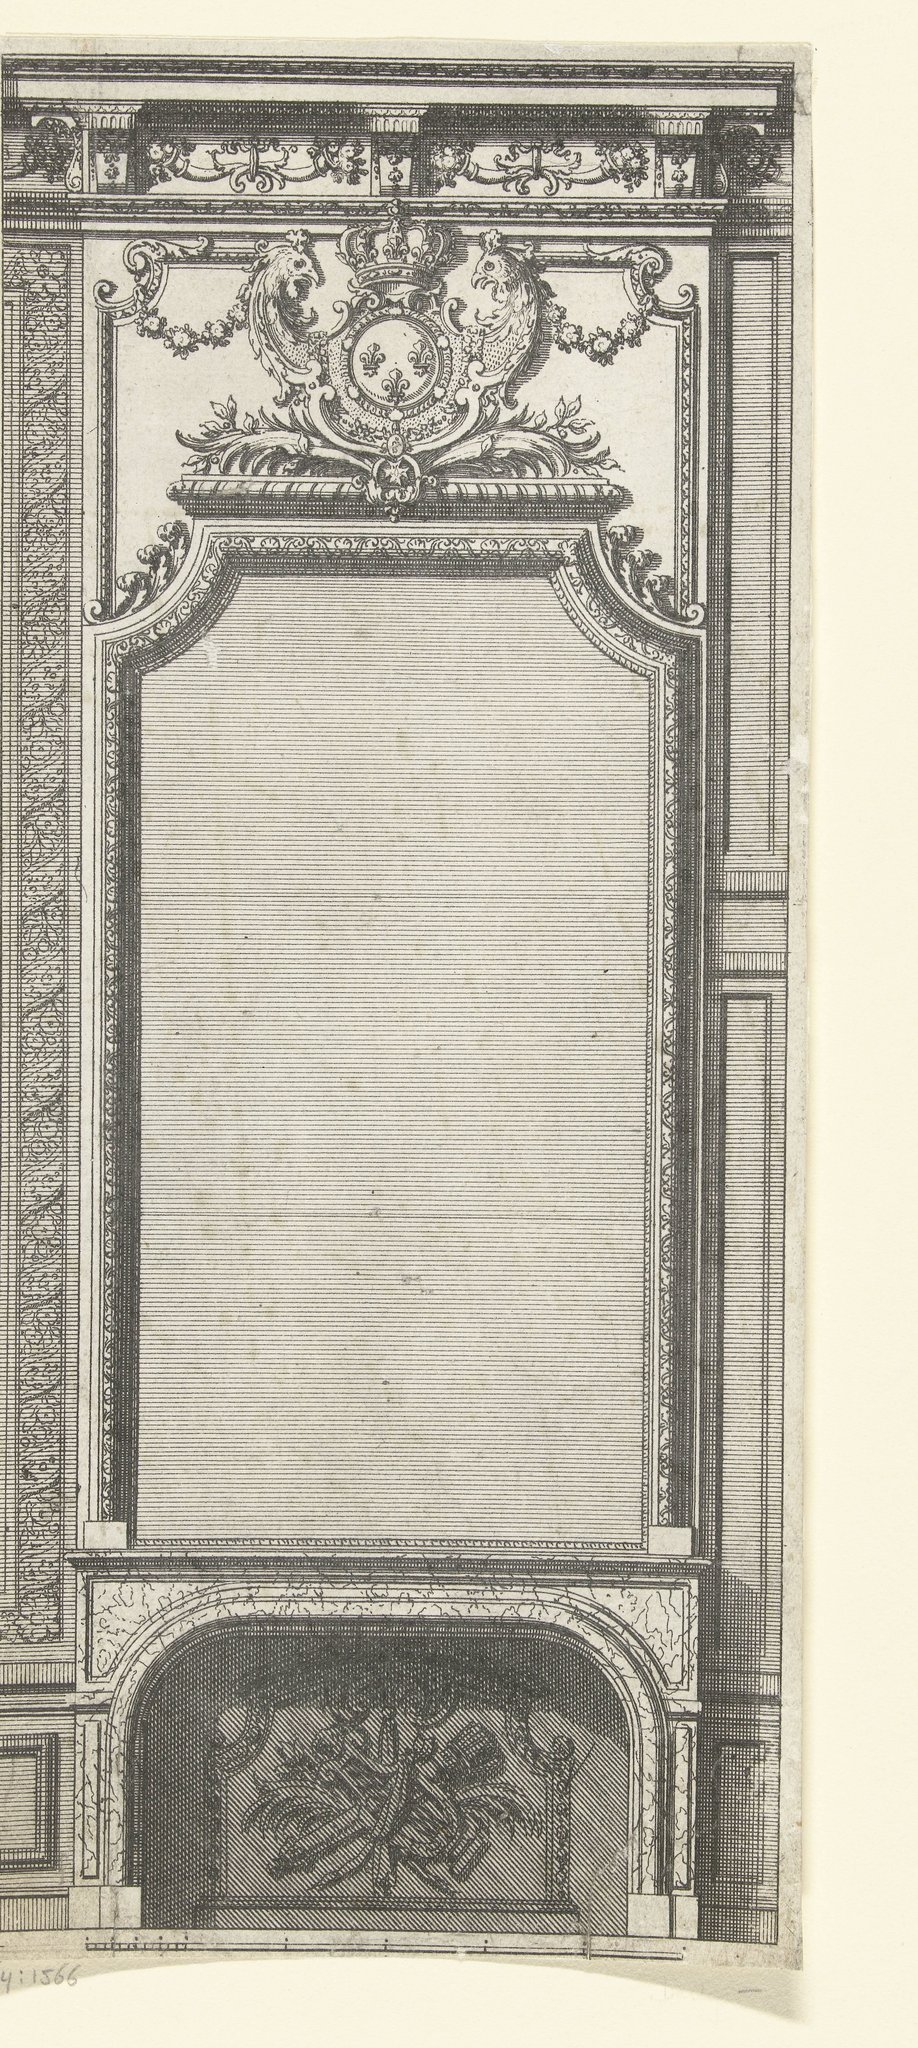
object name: ornament print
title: Schoorsteen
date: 1670-1699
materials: paper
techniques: etching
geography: paris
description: Niet in Berlin. Guilmard. Zie Fishe Kimball, The Creation of the Rococo, p.68 (vermeld reeks in Met.Mus.N.Y. als uniek). Zie ook: Metrop.Mus. Studies, Vol. V, p.274 e.v.